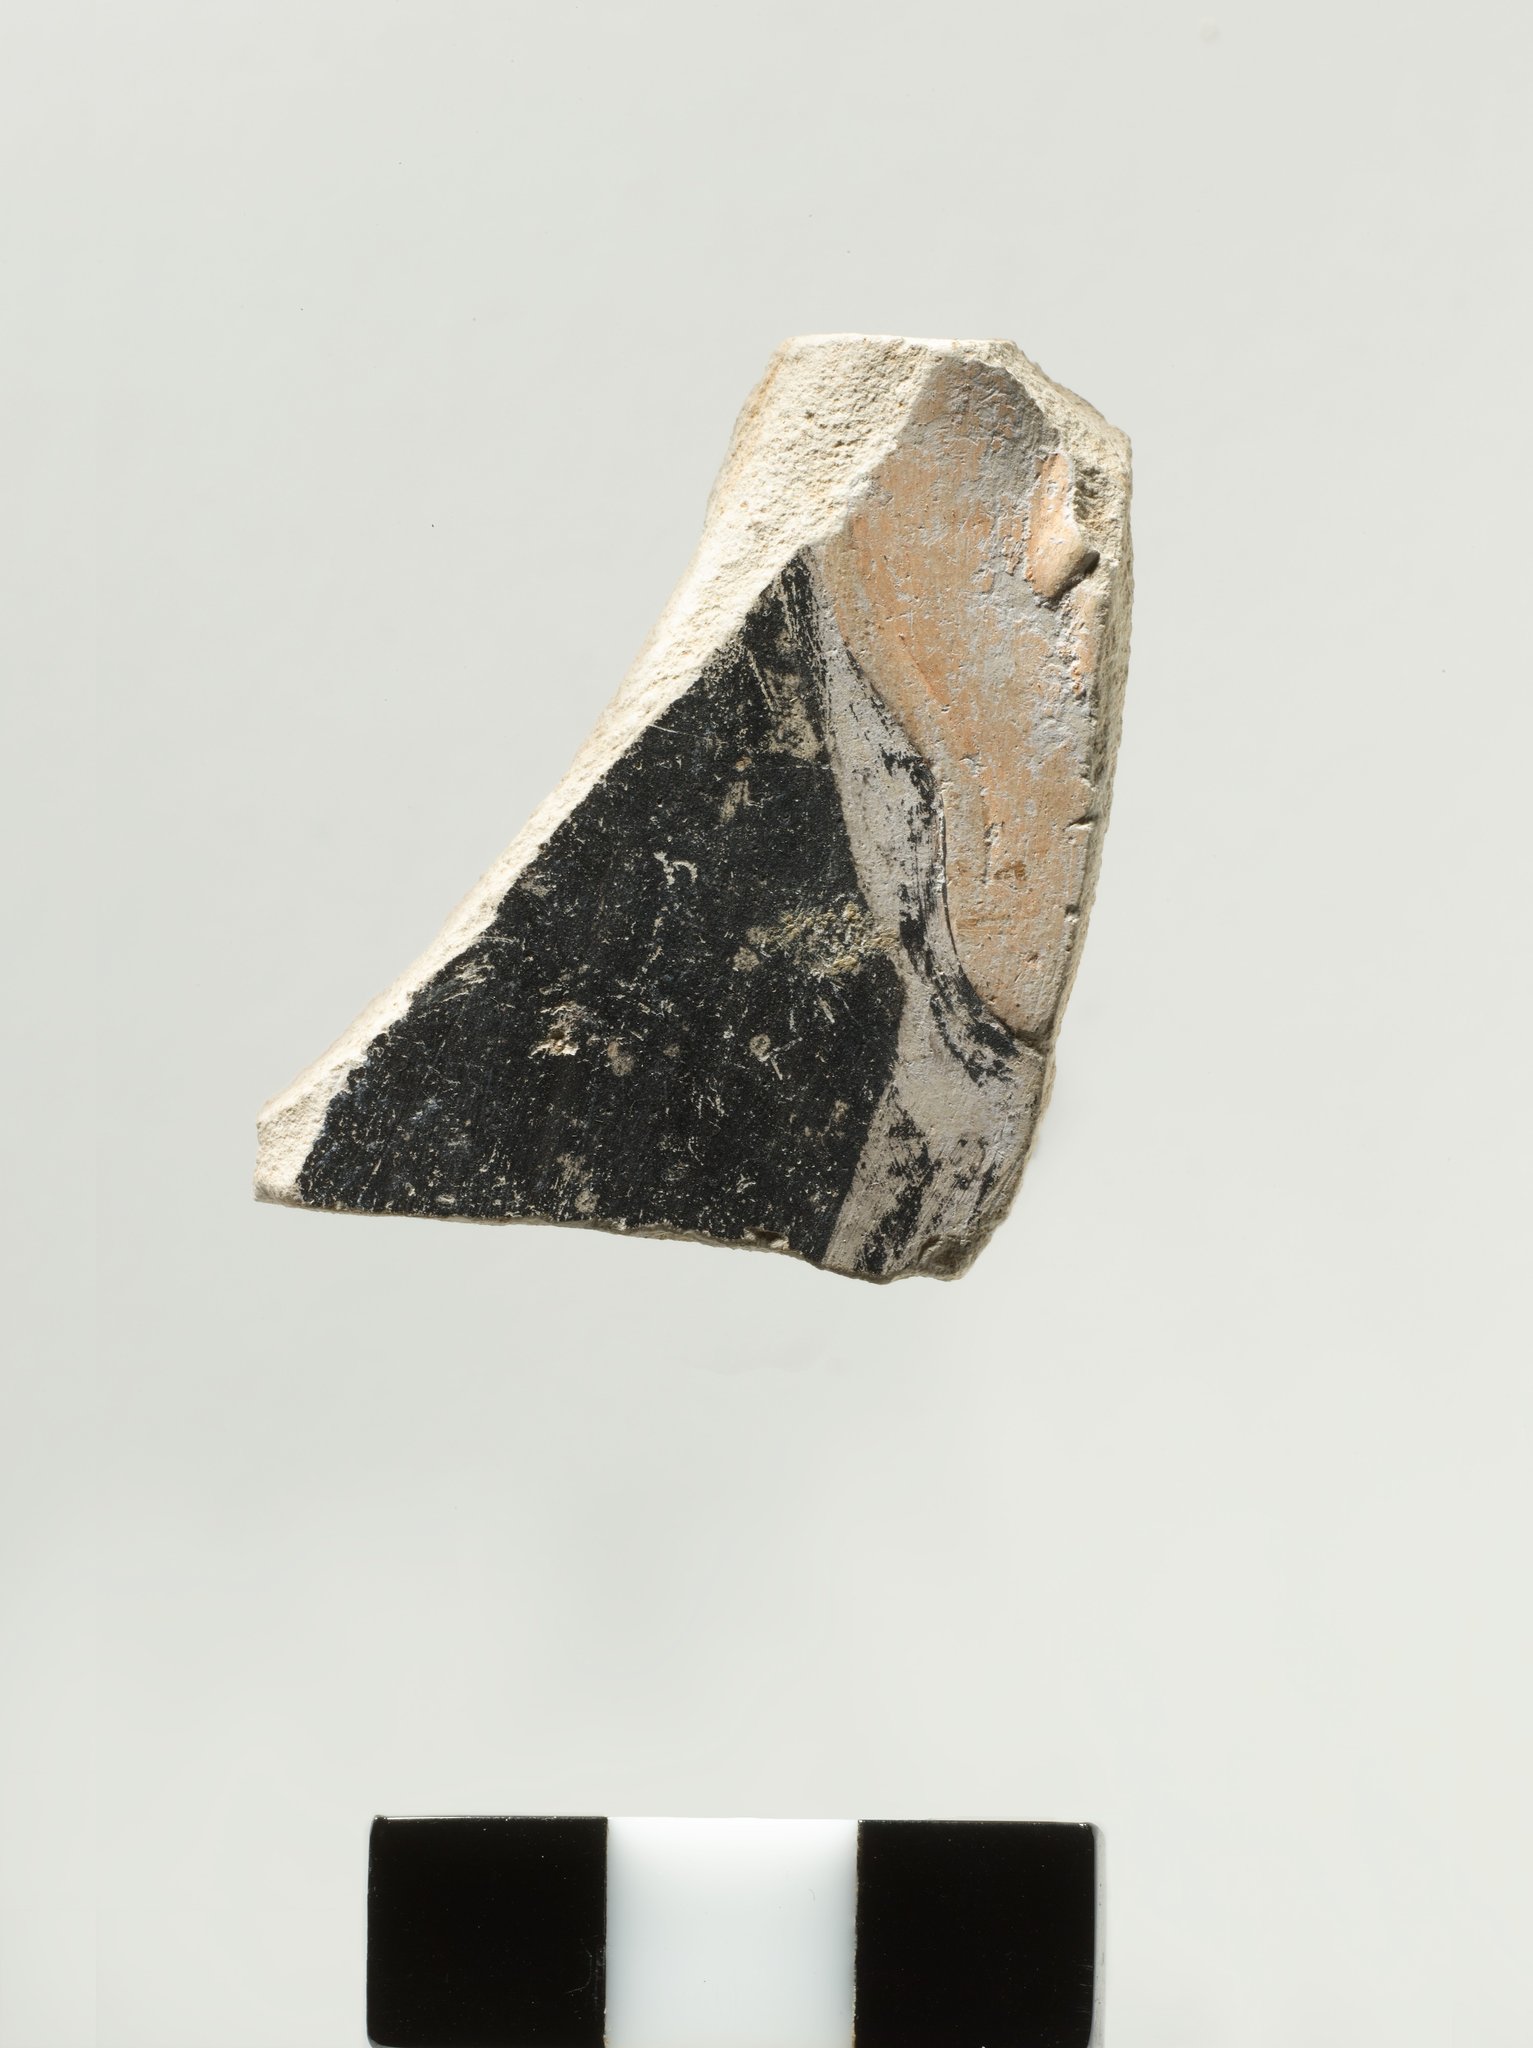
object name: relief fragment, tomb of meketre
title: Relief fragment from the tomb of Meketre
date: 1981-1975 BCE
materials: limestone, paint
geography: egypt